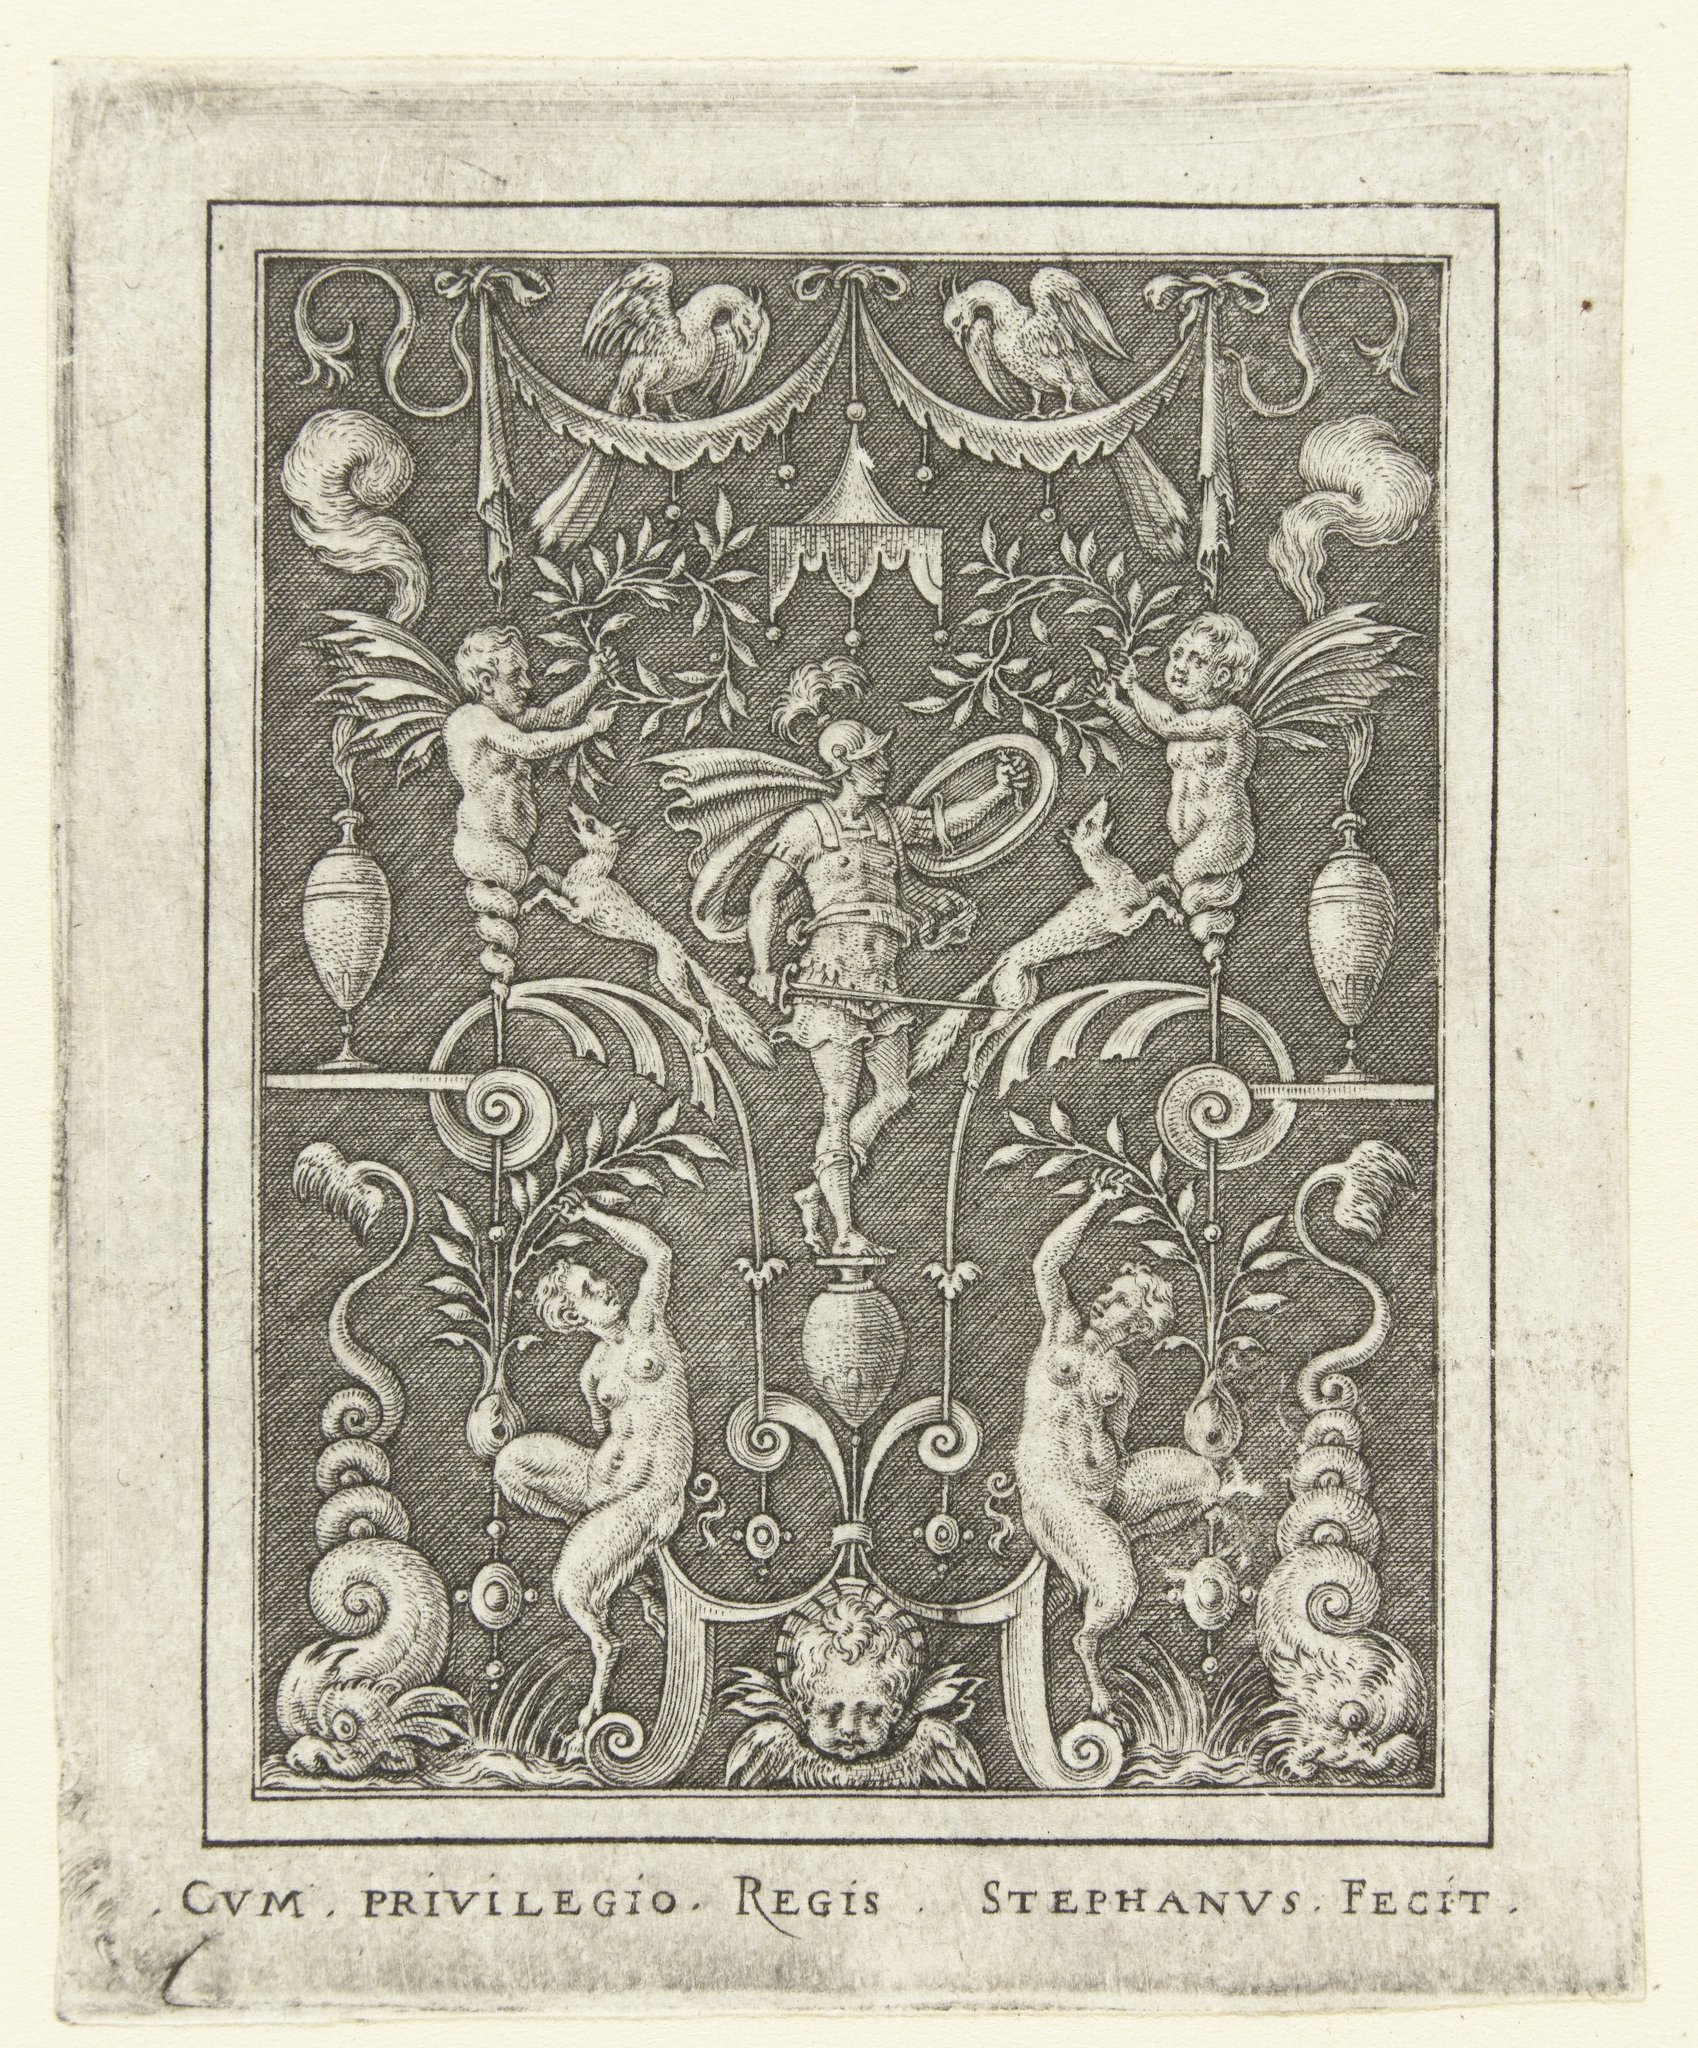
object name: ornament print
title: Vlakdecoraties met godenfiguren in een omlijsting van grotesken (latere versie)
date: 1528-1583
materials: paper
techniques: engraving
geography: france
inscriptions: collector's mark: Lugt 240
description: Mars met een schild en zwaard tussen twee vossen die opspringen tegen hermen in de vorm van putti. Uit serie van 6 bladen.